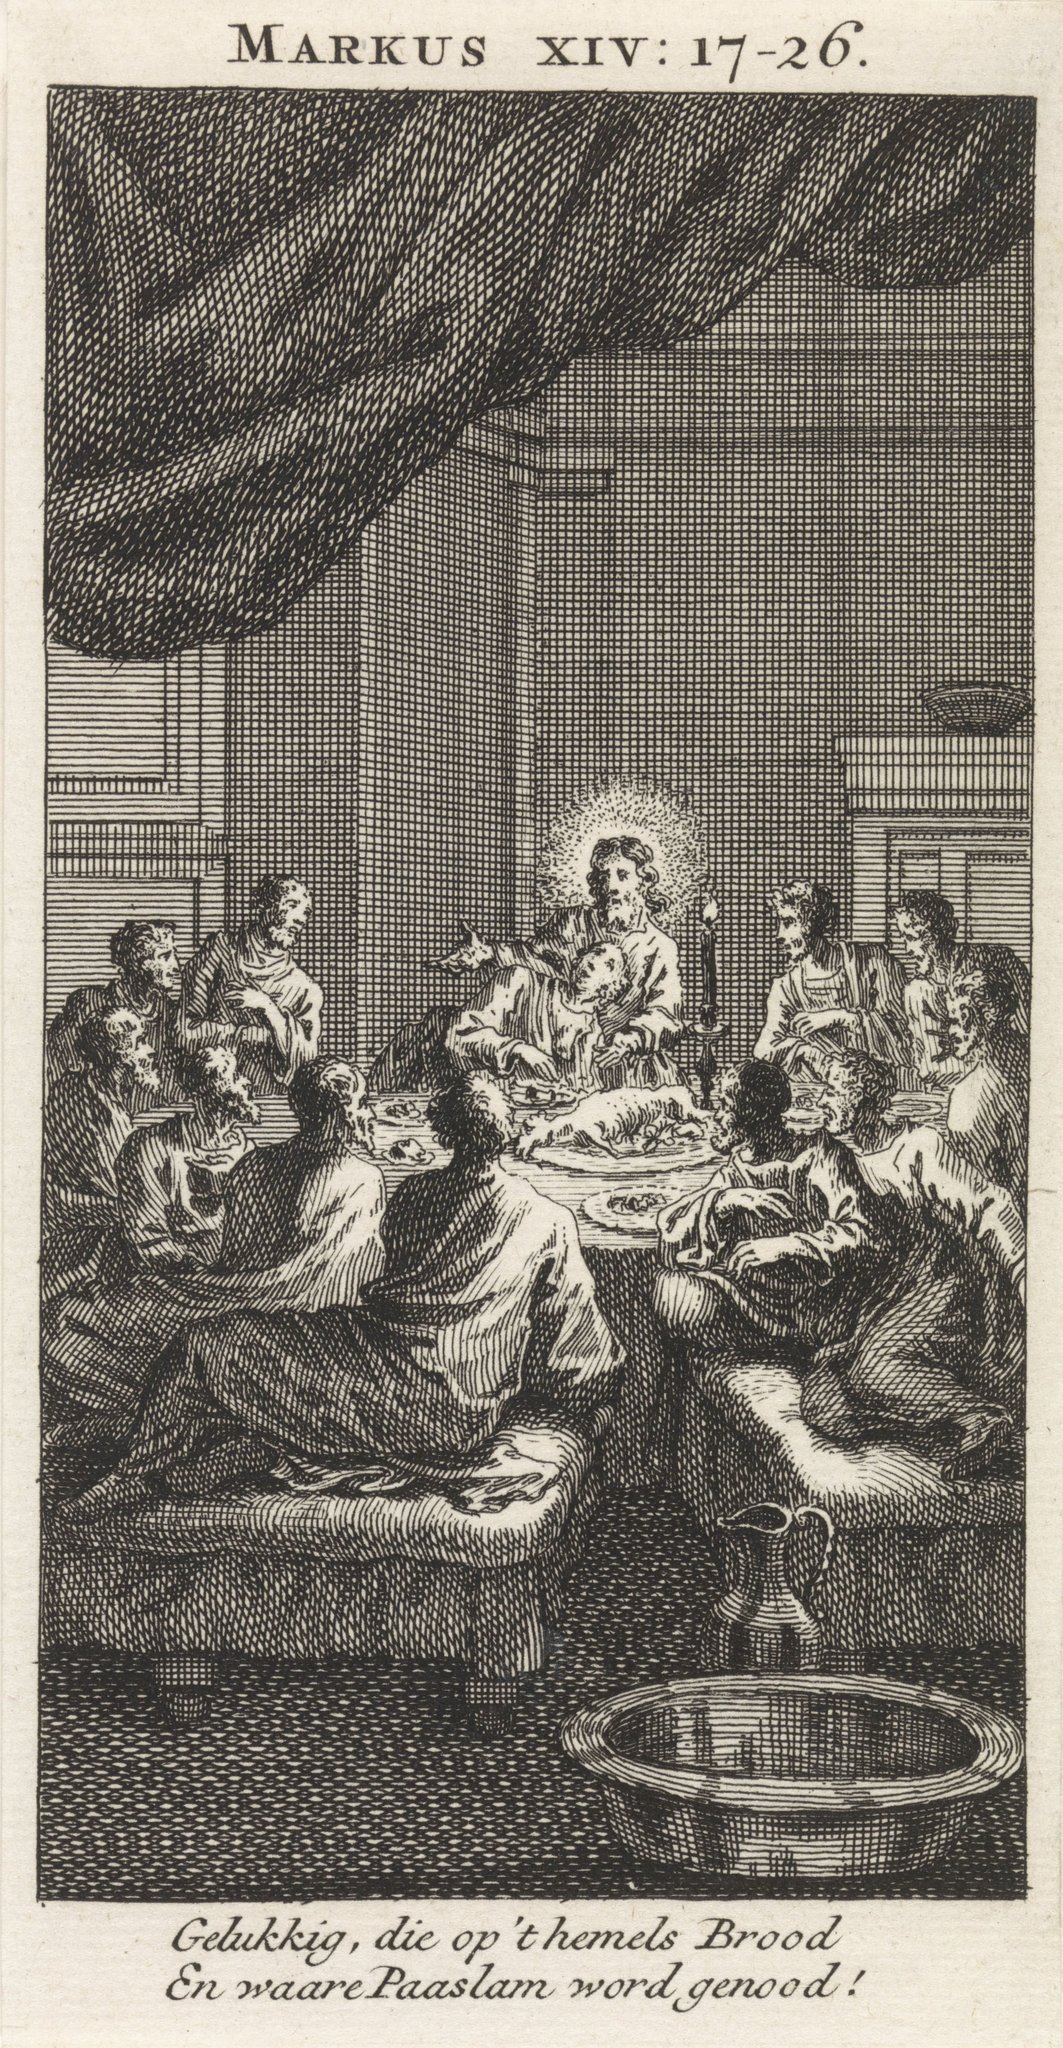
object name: print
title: Laatste Avondmaal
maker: Anonymous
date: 1712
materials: paper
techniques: etching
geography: amsterdam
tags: last supper (in general) (matthew 26:21-35; mark 14:18-31; luke 22:3, 22:15-23; john 13:21-38)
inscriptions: collector's mark: Lugt 2228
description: Kopie naar illustratie voor: Luyken, Jan. Bybel printen. Amsterdam: Pieter Arentsz. II (wed.) en Cornelis van der Sys, 1712, p. 24.